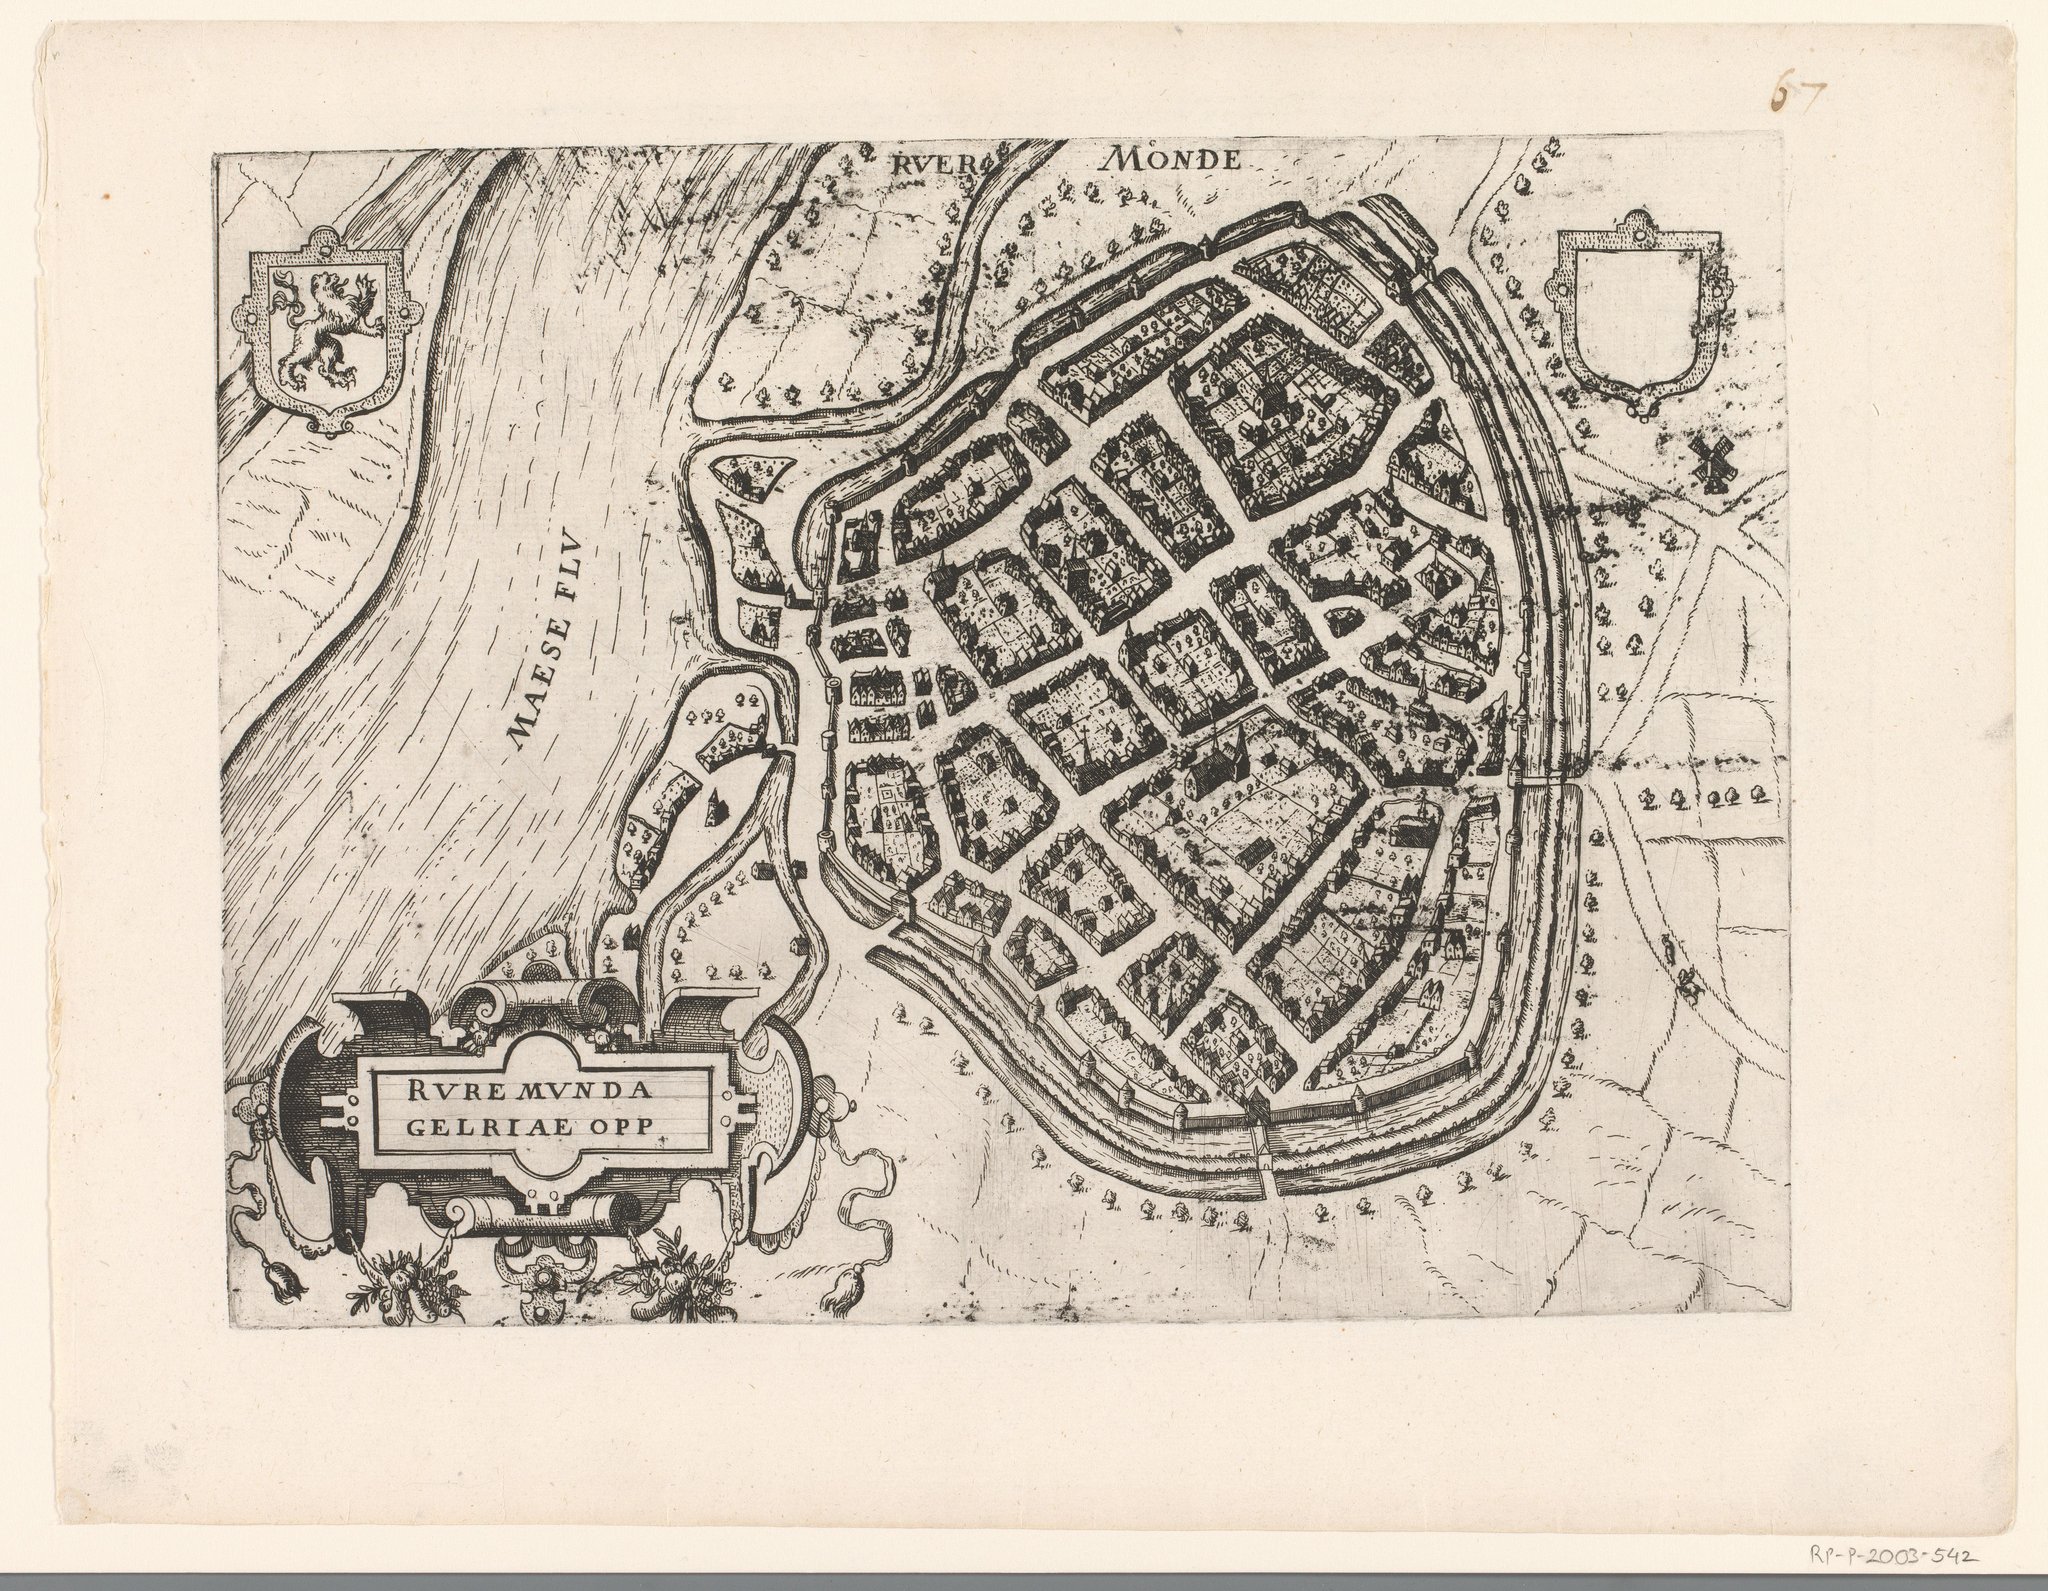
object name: area plan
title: Ruermonde / Ruremunda | Gelriae Opp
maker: Anonymous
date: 1607-1609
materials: paper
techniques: etching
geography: southern netherlands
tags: maps of cities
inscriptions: number: ‘67’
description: Plattegrond van de stad Roermond. Midden boven de titel, links het wapen van het hertogdom Limburg, rechts een blanco wapen. Linksonder een cartouche met de Latijnse titel. Onderdeel van de verzameling kaarten genomen uit een latere editie van: Descrittione di tutti i Paesi Bassi van Lodovico Guicciardini.